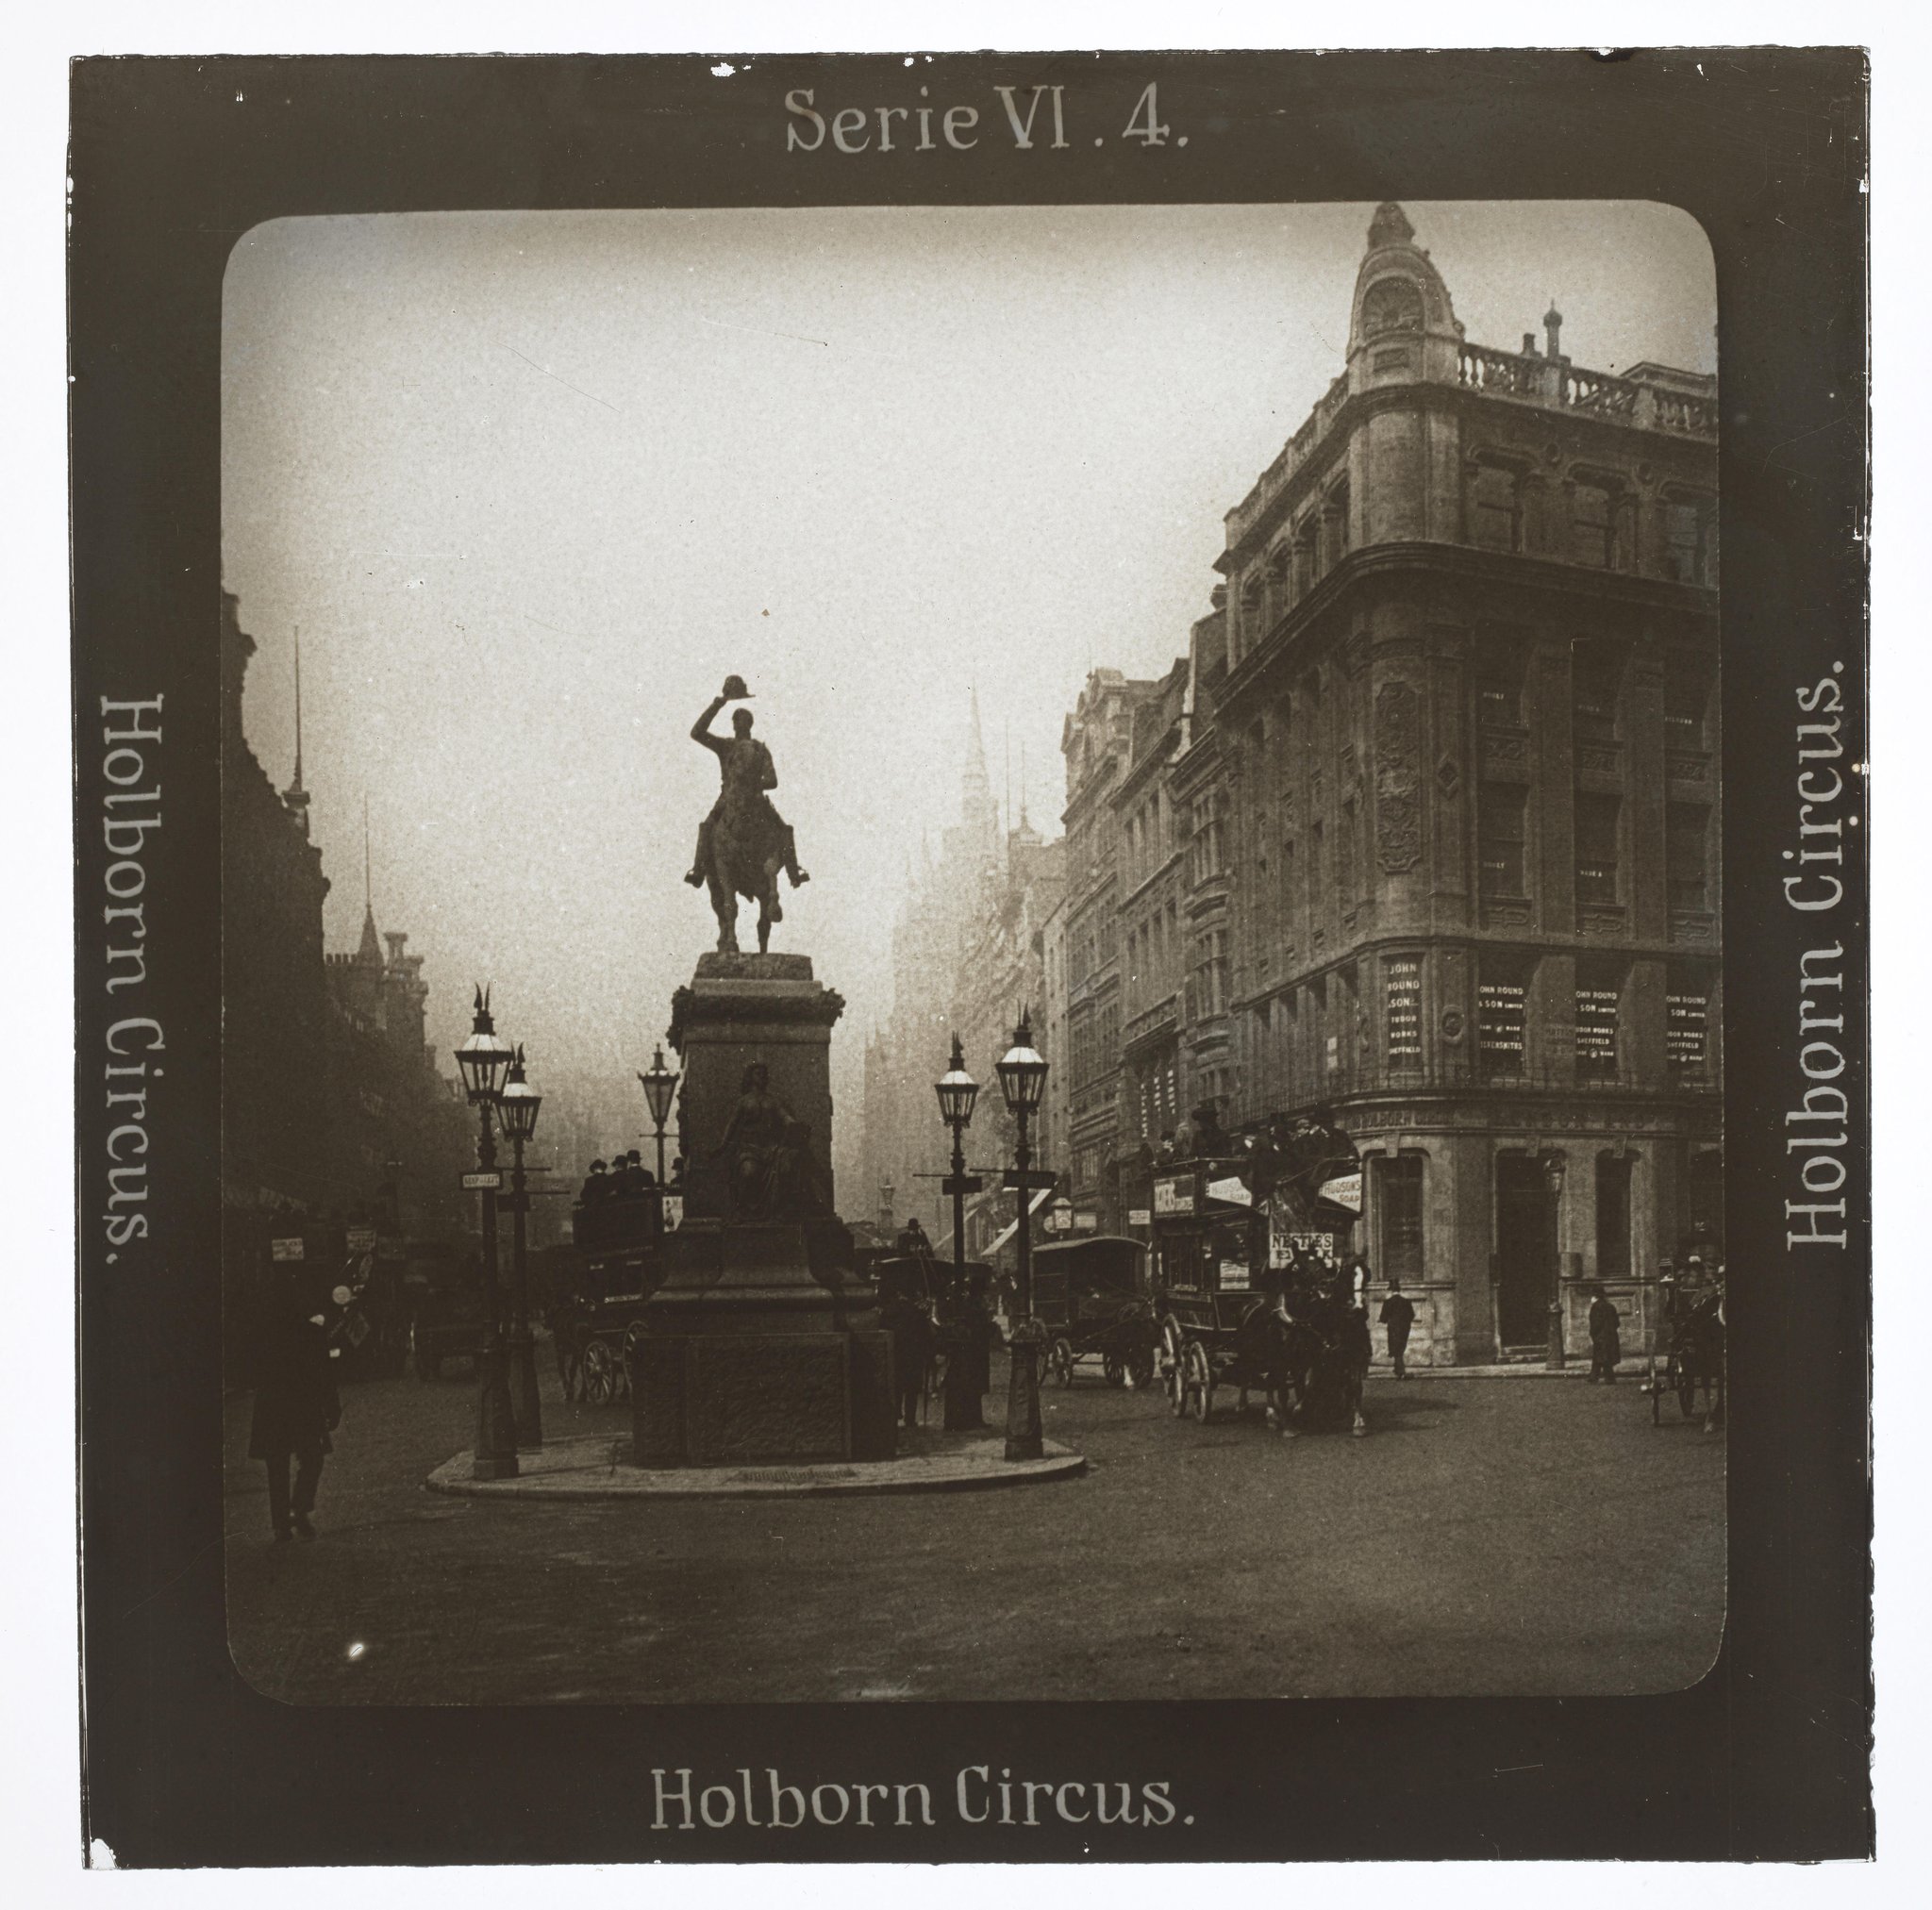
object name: lantern slide photographic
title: Holborn Circus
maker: Anonymous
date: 1900-1906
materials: glass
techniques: gelatin silver transparency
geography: germany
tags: square, place, circus, etc., monument, statue